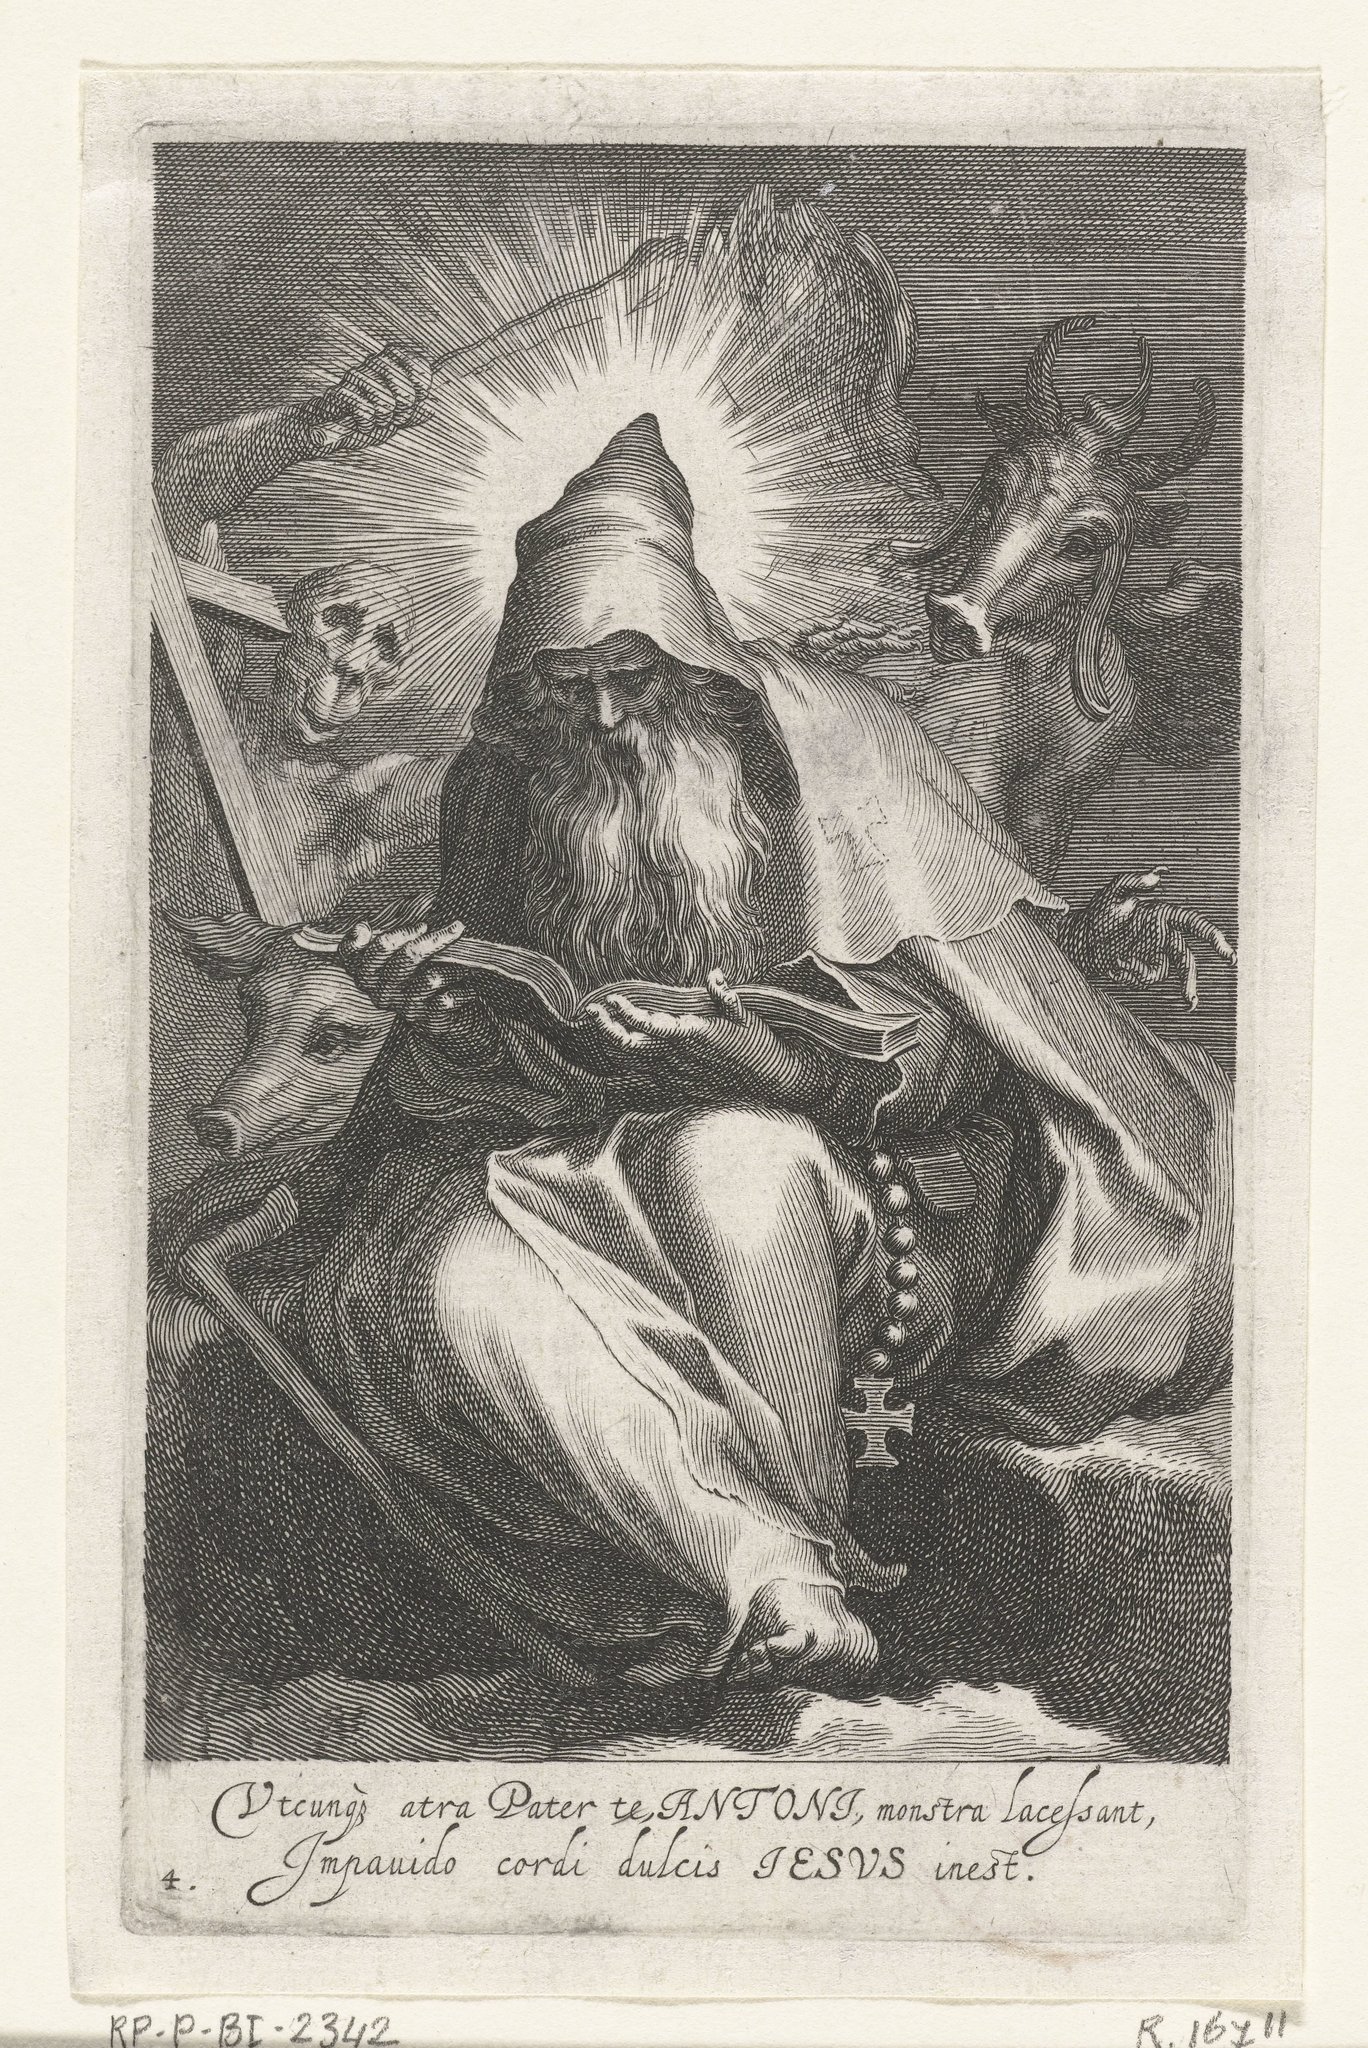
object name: print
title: Ad sacrum speculum (...) patribus dat ales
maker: boëtius adamsz. bolswert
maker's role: print maker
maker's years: 1580-1633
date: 1590-1612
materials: paper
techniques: engraving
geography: amsterdam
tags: the hermit antony abbot (antonius abbas) of egypt, also called the great; possible attributes: bell, book, t-shaped staff, flames, pig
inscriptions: collector's mark: Lugt 240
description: Prent uit: Ad sacrum speculum recurris? ... patribus dat ales, geen plaats, Boëtius Adamsz. Bolswert, 1612. Tweede ongebonden uitgave met in totaal vijftig prenten. Prent uit serie van drieentwintig mannelijke kluizenaars. In 1619 verscheen een gebonden editie maar op basis van de gewijzigde opschriften en samenstelling wordt aangenomen dat deze prenten ook in 1612 of iets daarvoor gedrukt werden. Roethlisberger beschouwt de uitgave van 1619 als de eerste staat en de ongebonden editie van 1612 als de tweede staat (Roethlisberger 1993, p. 171, 172).